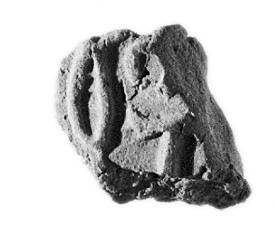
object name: sealing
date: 1981-1640 BCE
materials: mud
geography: egypt